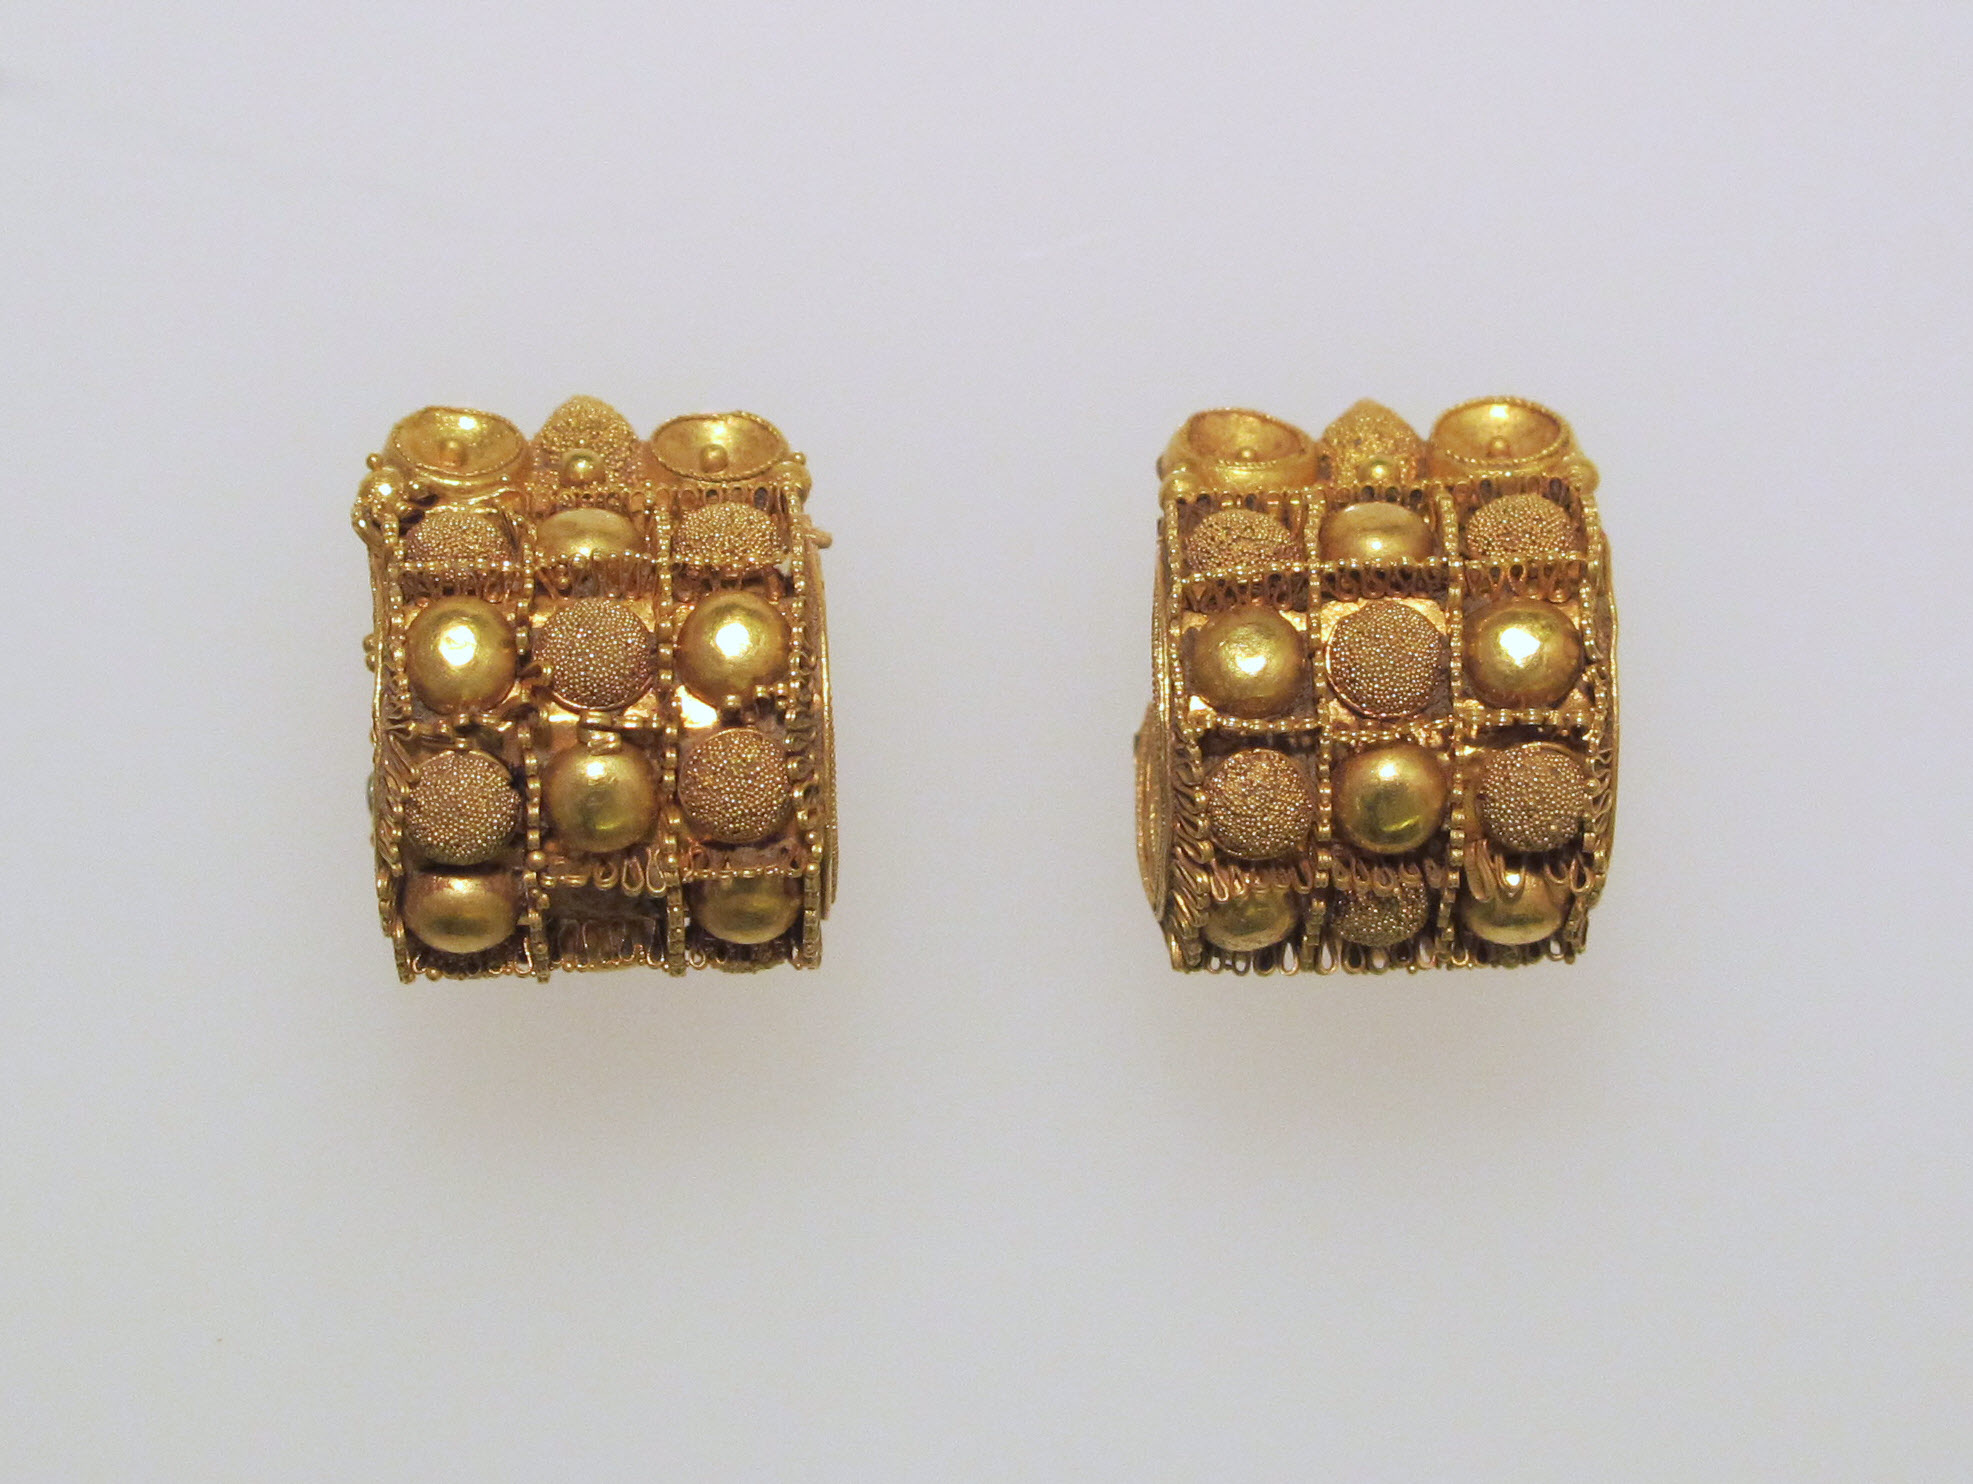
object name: earring, baule type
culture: etruscan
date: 700-401 BCE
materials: gold